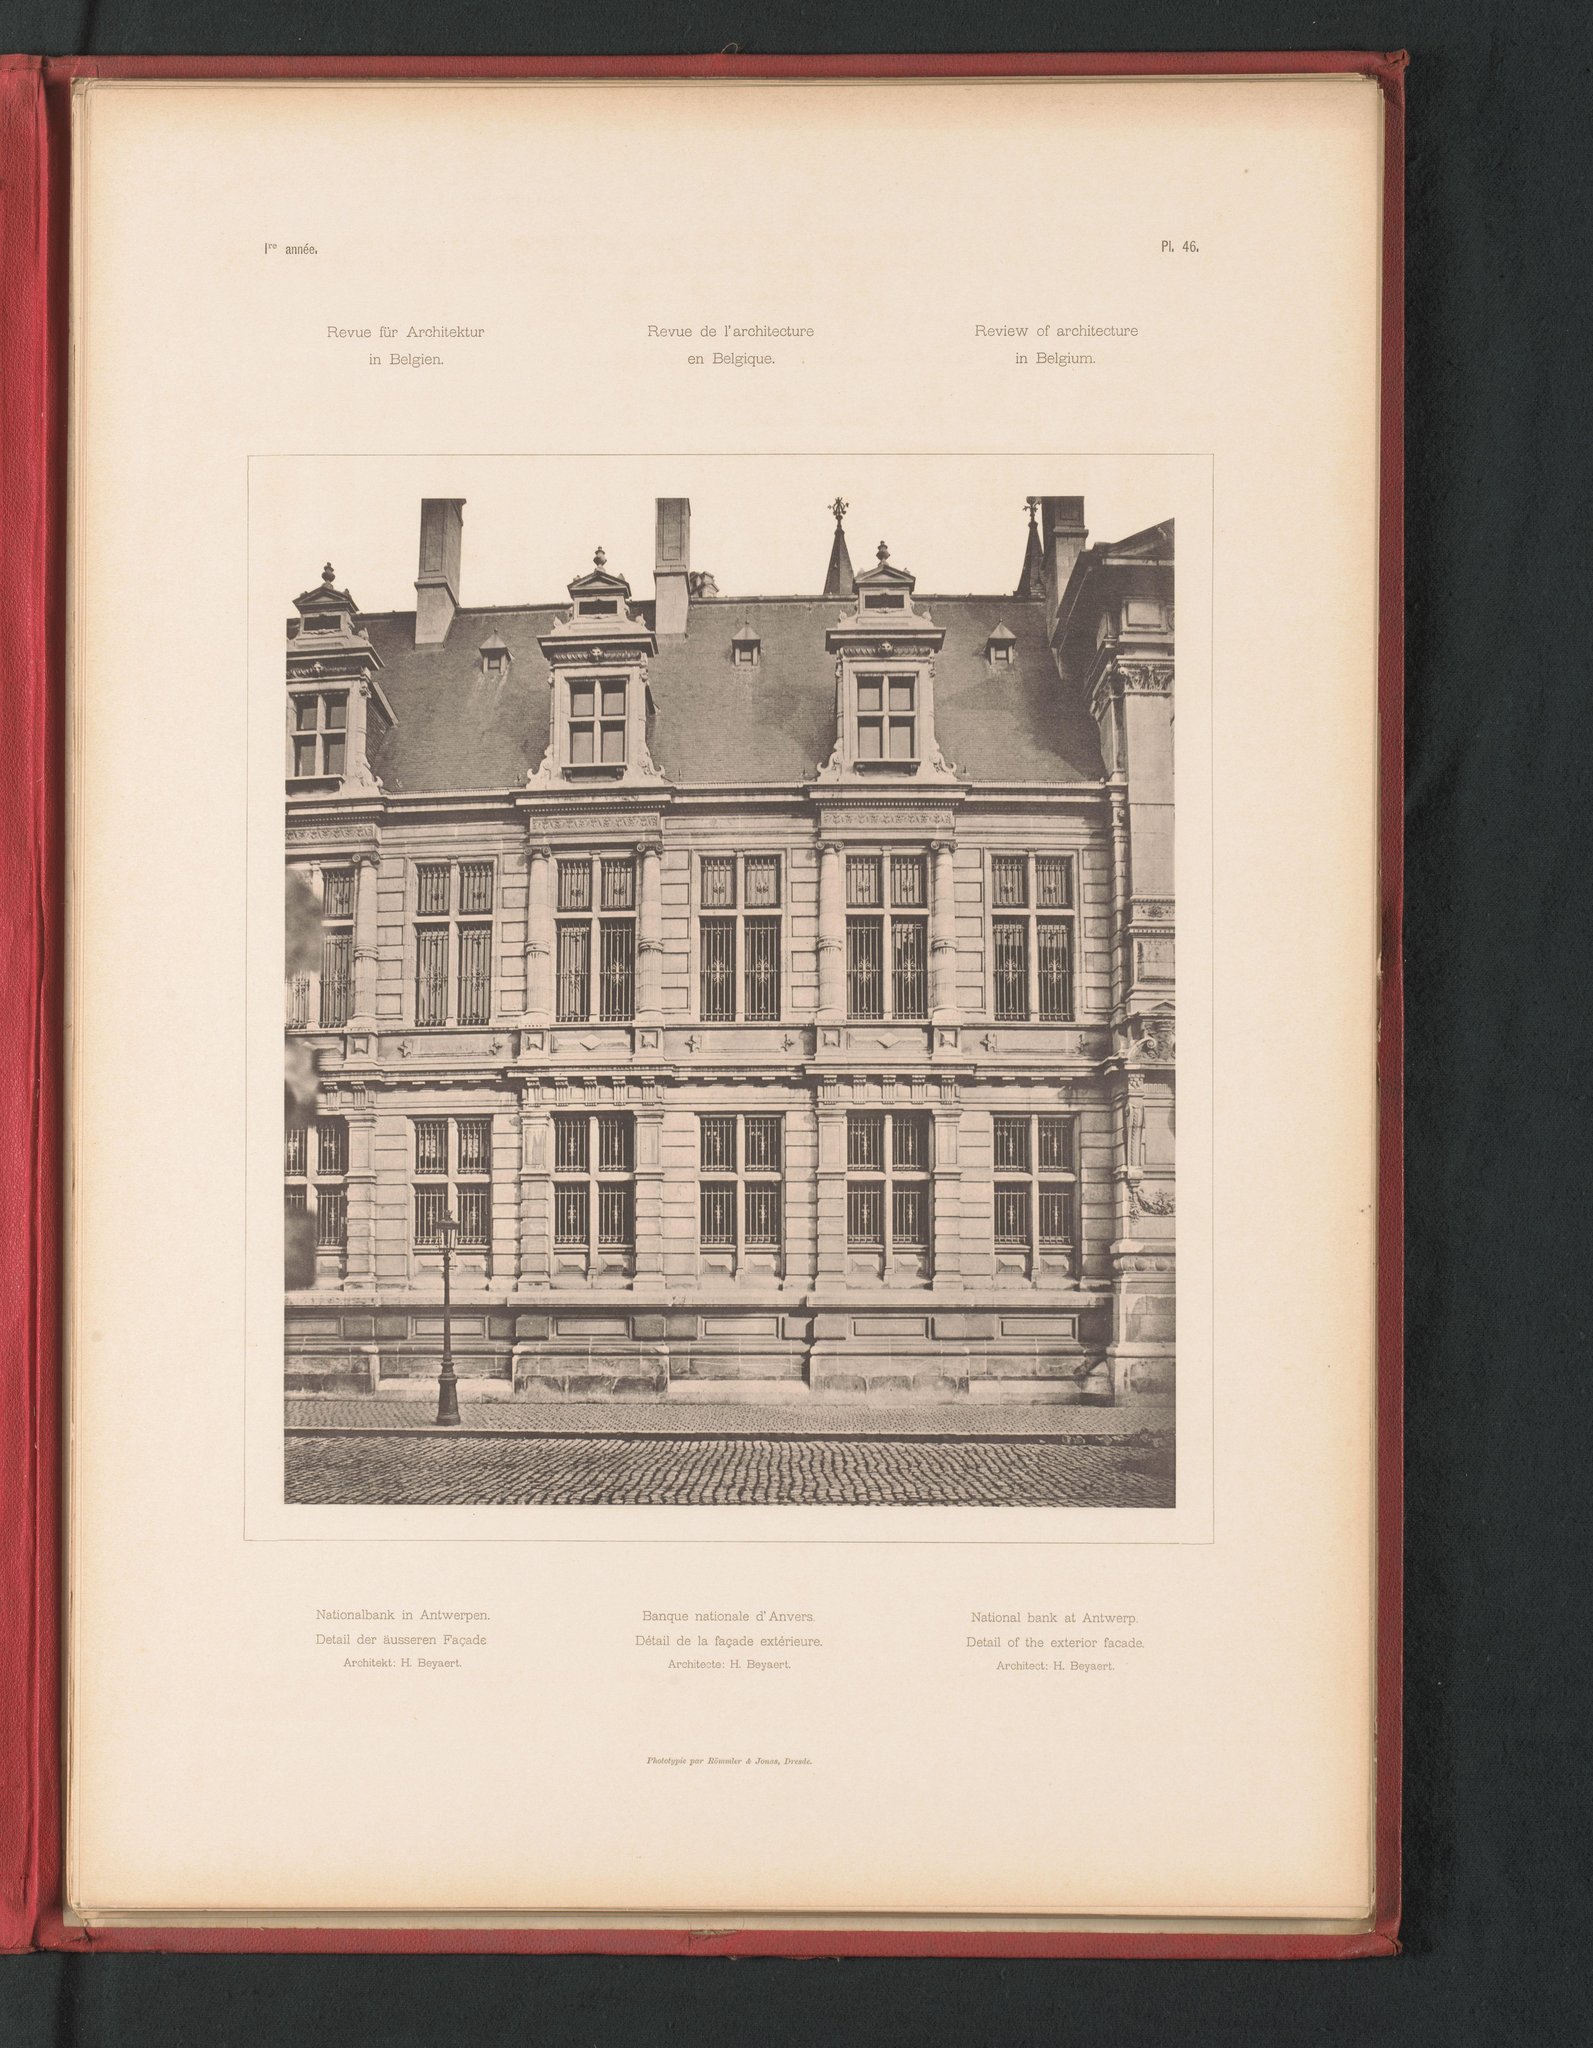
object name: photomechanical print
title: Gezicht op het gebouw van de nationale bank in Antwerpen, België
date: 1888-1893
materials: paper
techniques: photograph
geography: dresden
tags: bank, antwerp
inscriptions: inscription: ‘Architecte: H. Beyaert.’, inscription: ‘Architect: H. Beyaert.’, inscription: ‘Architekt: H. Beyaert.’, number: ‘Pl. 46.’, inscription: ‘1re annèe.’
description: Deze prent maakt deel uit van een omslag met 110 prenten op 90 bladen en 18 tekstbladen.